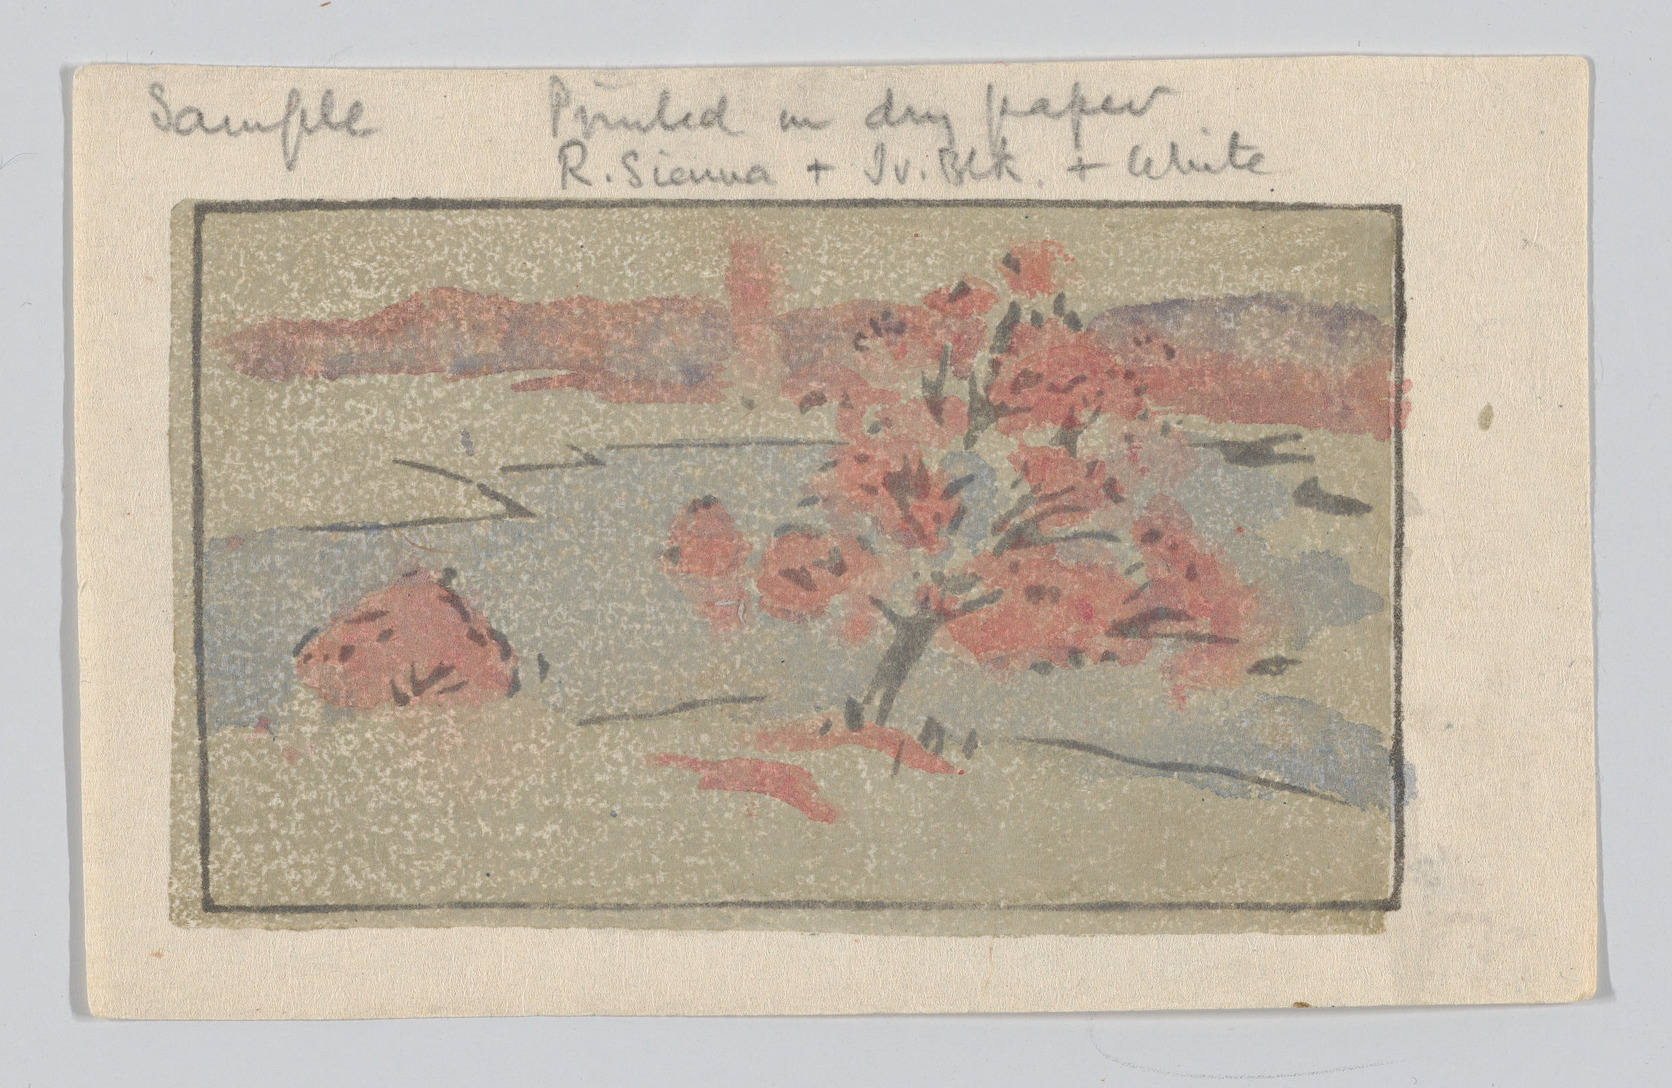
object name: woodcut, print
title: Nabby's Point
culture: american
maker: arthur wesley dow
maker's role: artist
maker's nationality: american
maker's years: 1857-1922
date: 1913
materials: paper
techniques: woodcut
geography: united states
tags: trees